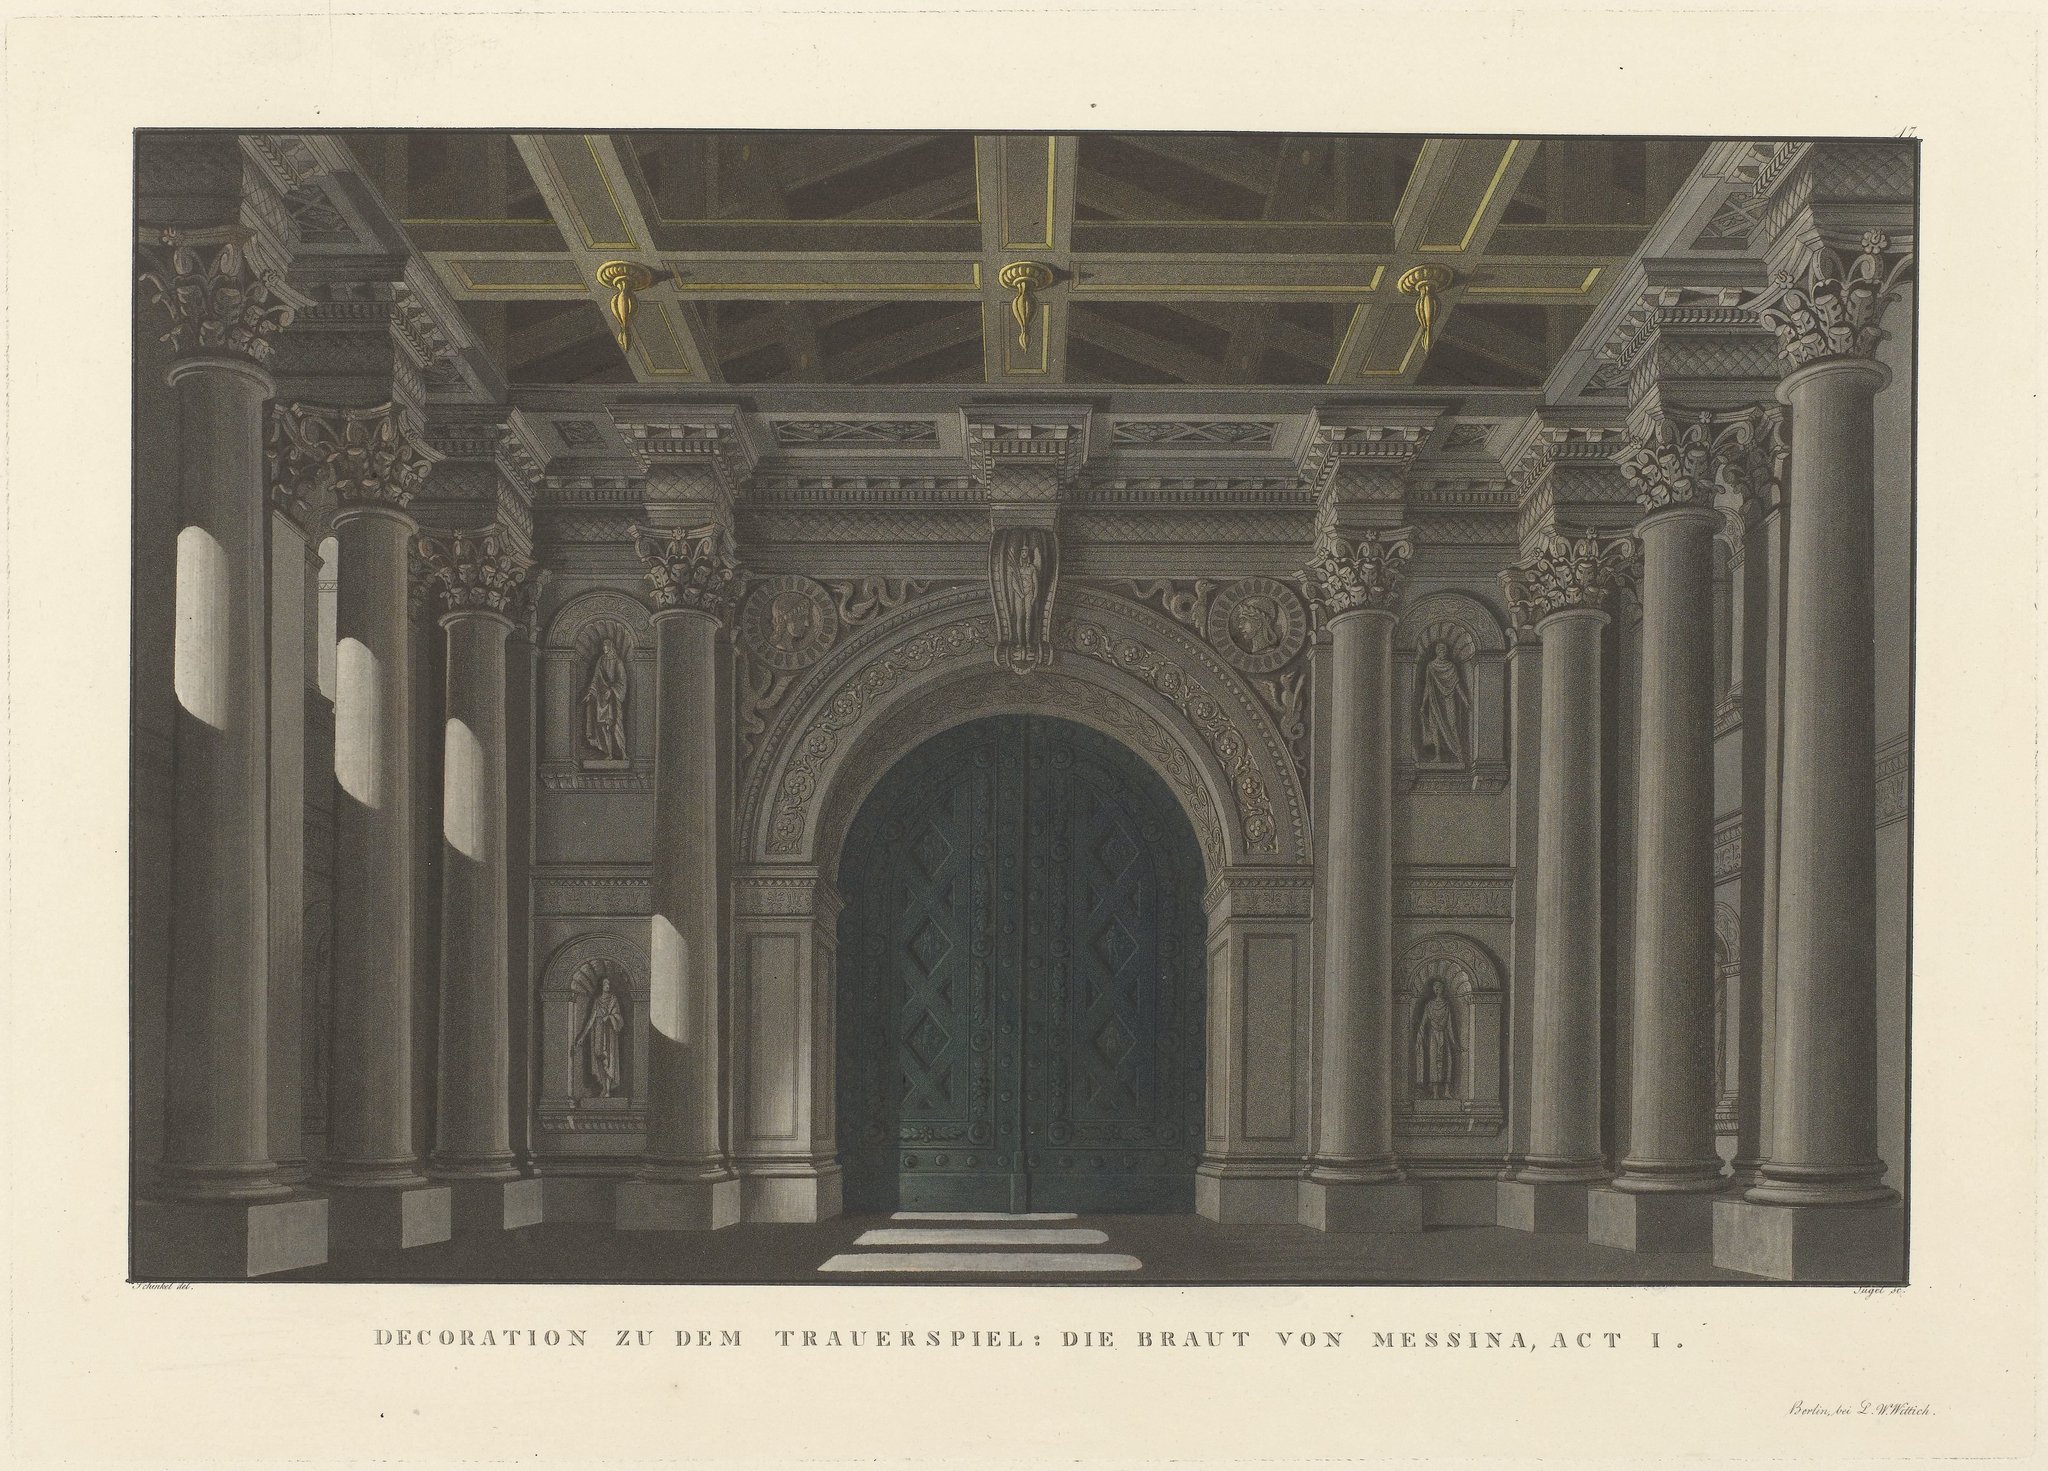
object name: print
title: Decorationen auf den beiden Königlichen Theatern in Berlin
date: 1824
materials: paper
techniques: aquatint, engraving, hand coloring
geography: berlin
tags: stage design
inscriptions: collector's mark: Lugt 2760, collector's mark: Lugt 2228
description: Weergave van het decor van de eerste act uit het theaterstuk door Friedrich Schillder, met lichtinval van linksboven.